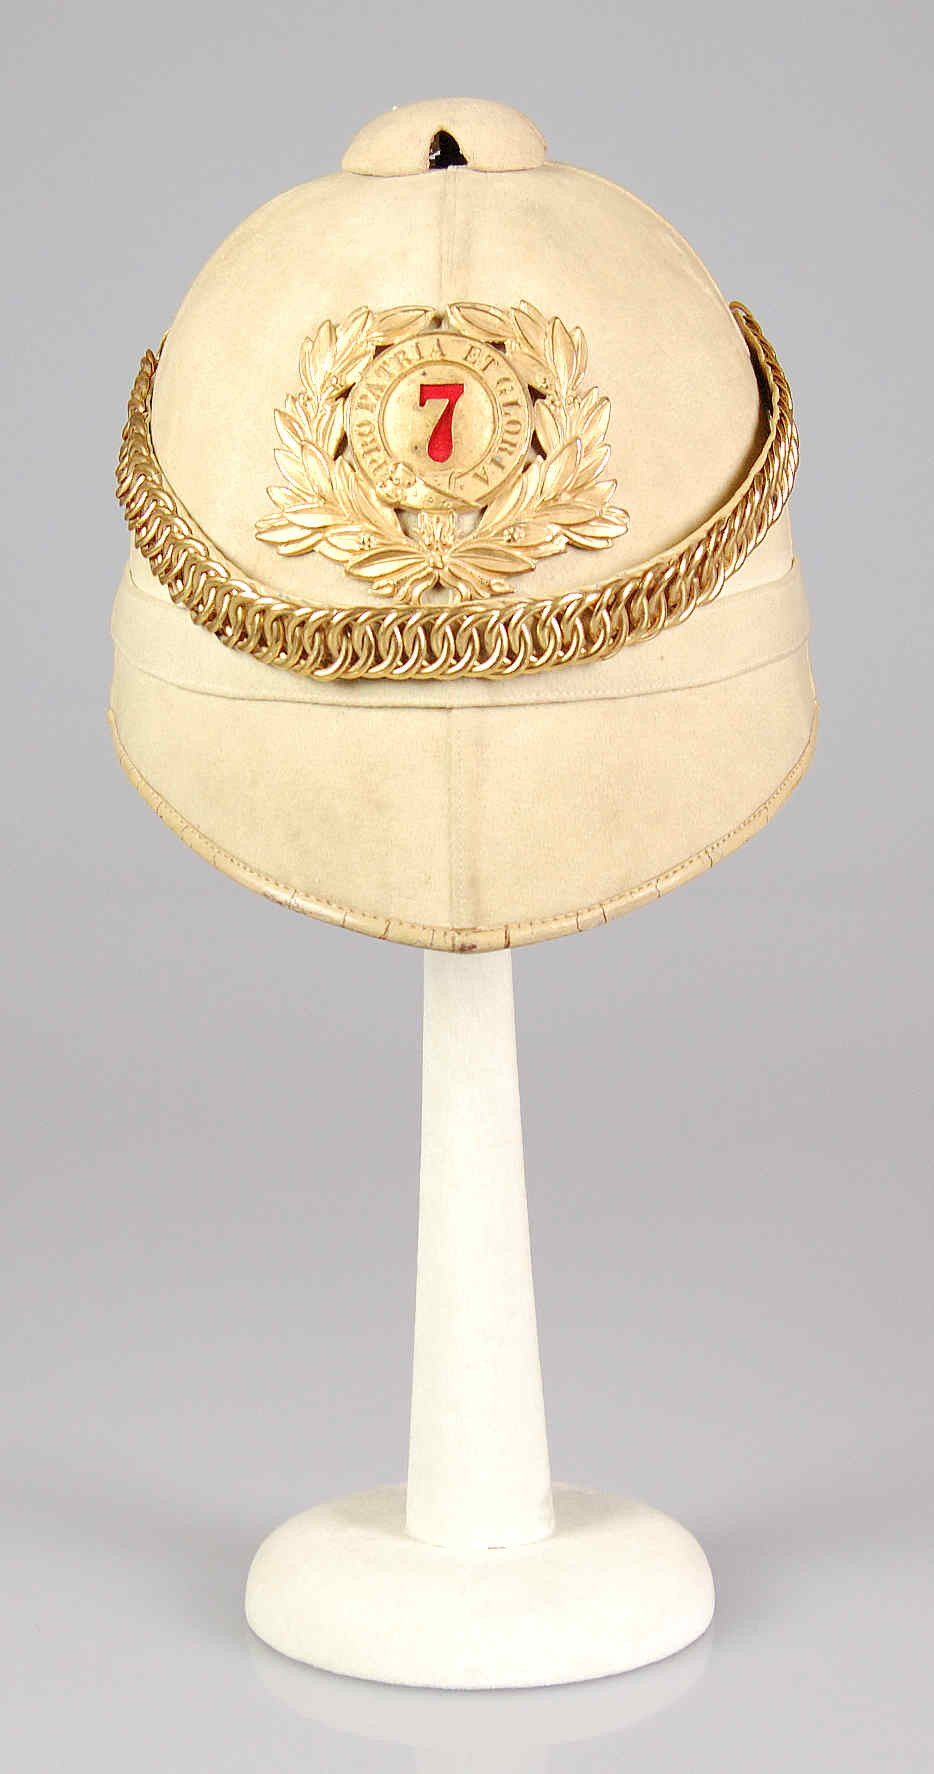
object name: military helmet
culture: american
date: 1890-1899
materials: leather, metal, wool